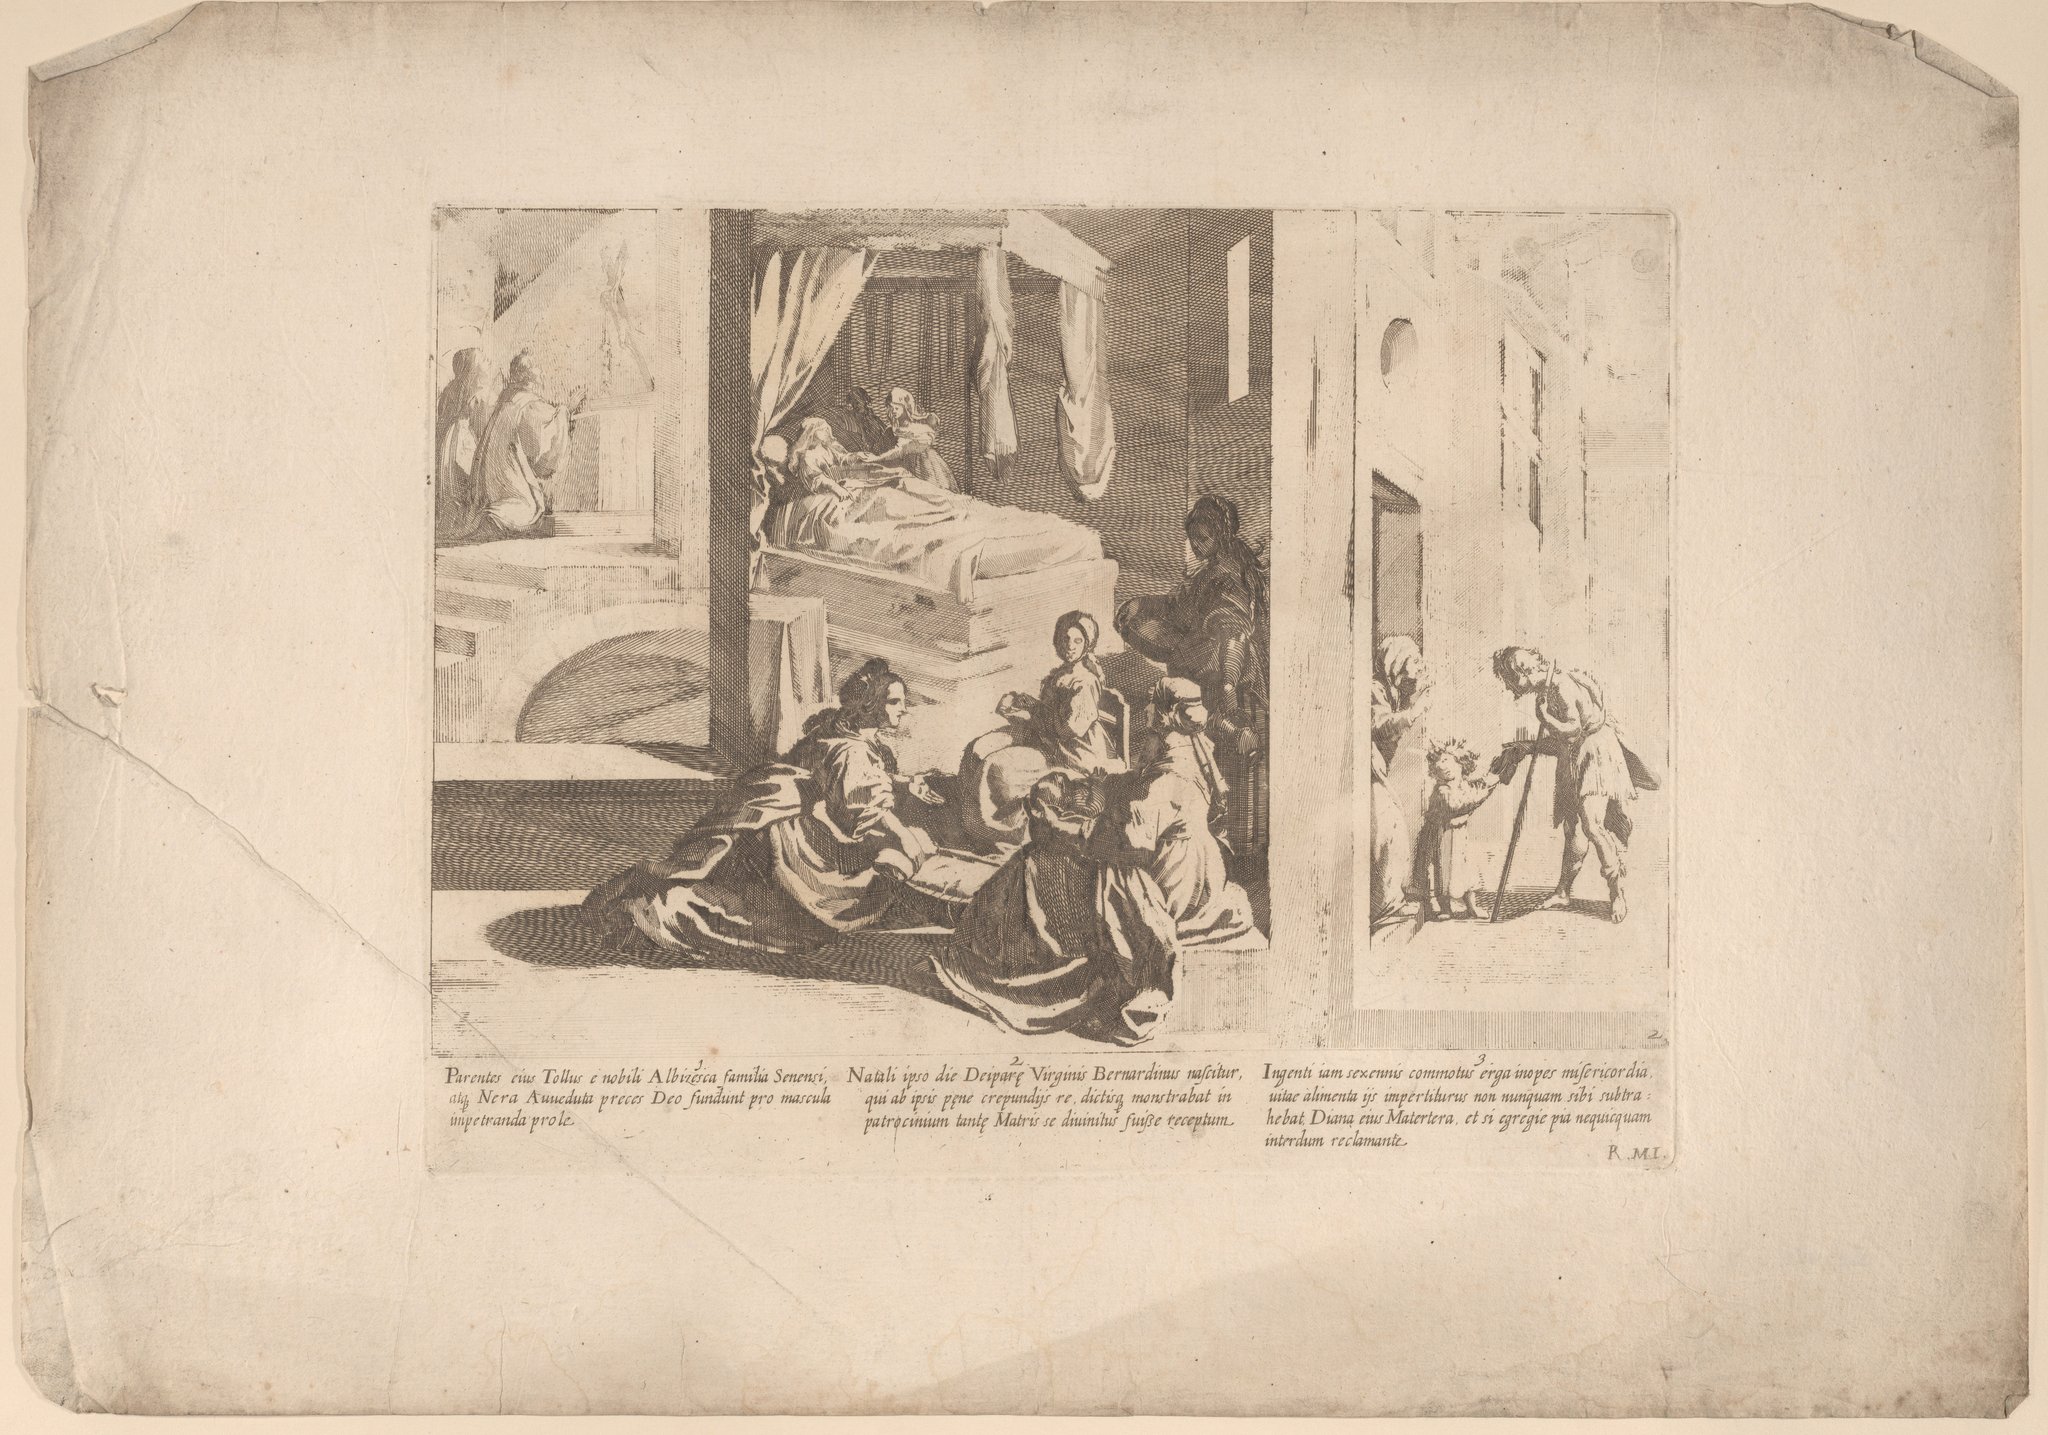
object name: print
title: Episode 1: Saint Bernardino's parents pray to God for a son; Episode 2: The Birth of Saint Bernardino; Episode 3: The Young Saint Bernardino performs an act of mercy, from "The Life of Saint Bernardino of Siena"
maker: bernardino capitelli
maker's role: artist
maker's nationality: italian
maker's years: 1590-1639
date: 1610-1639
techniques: etching